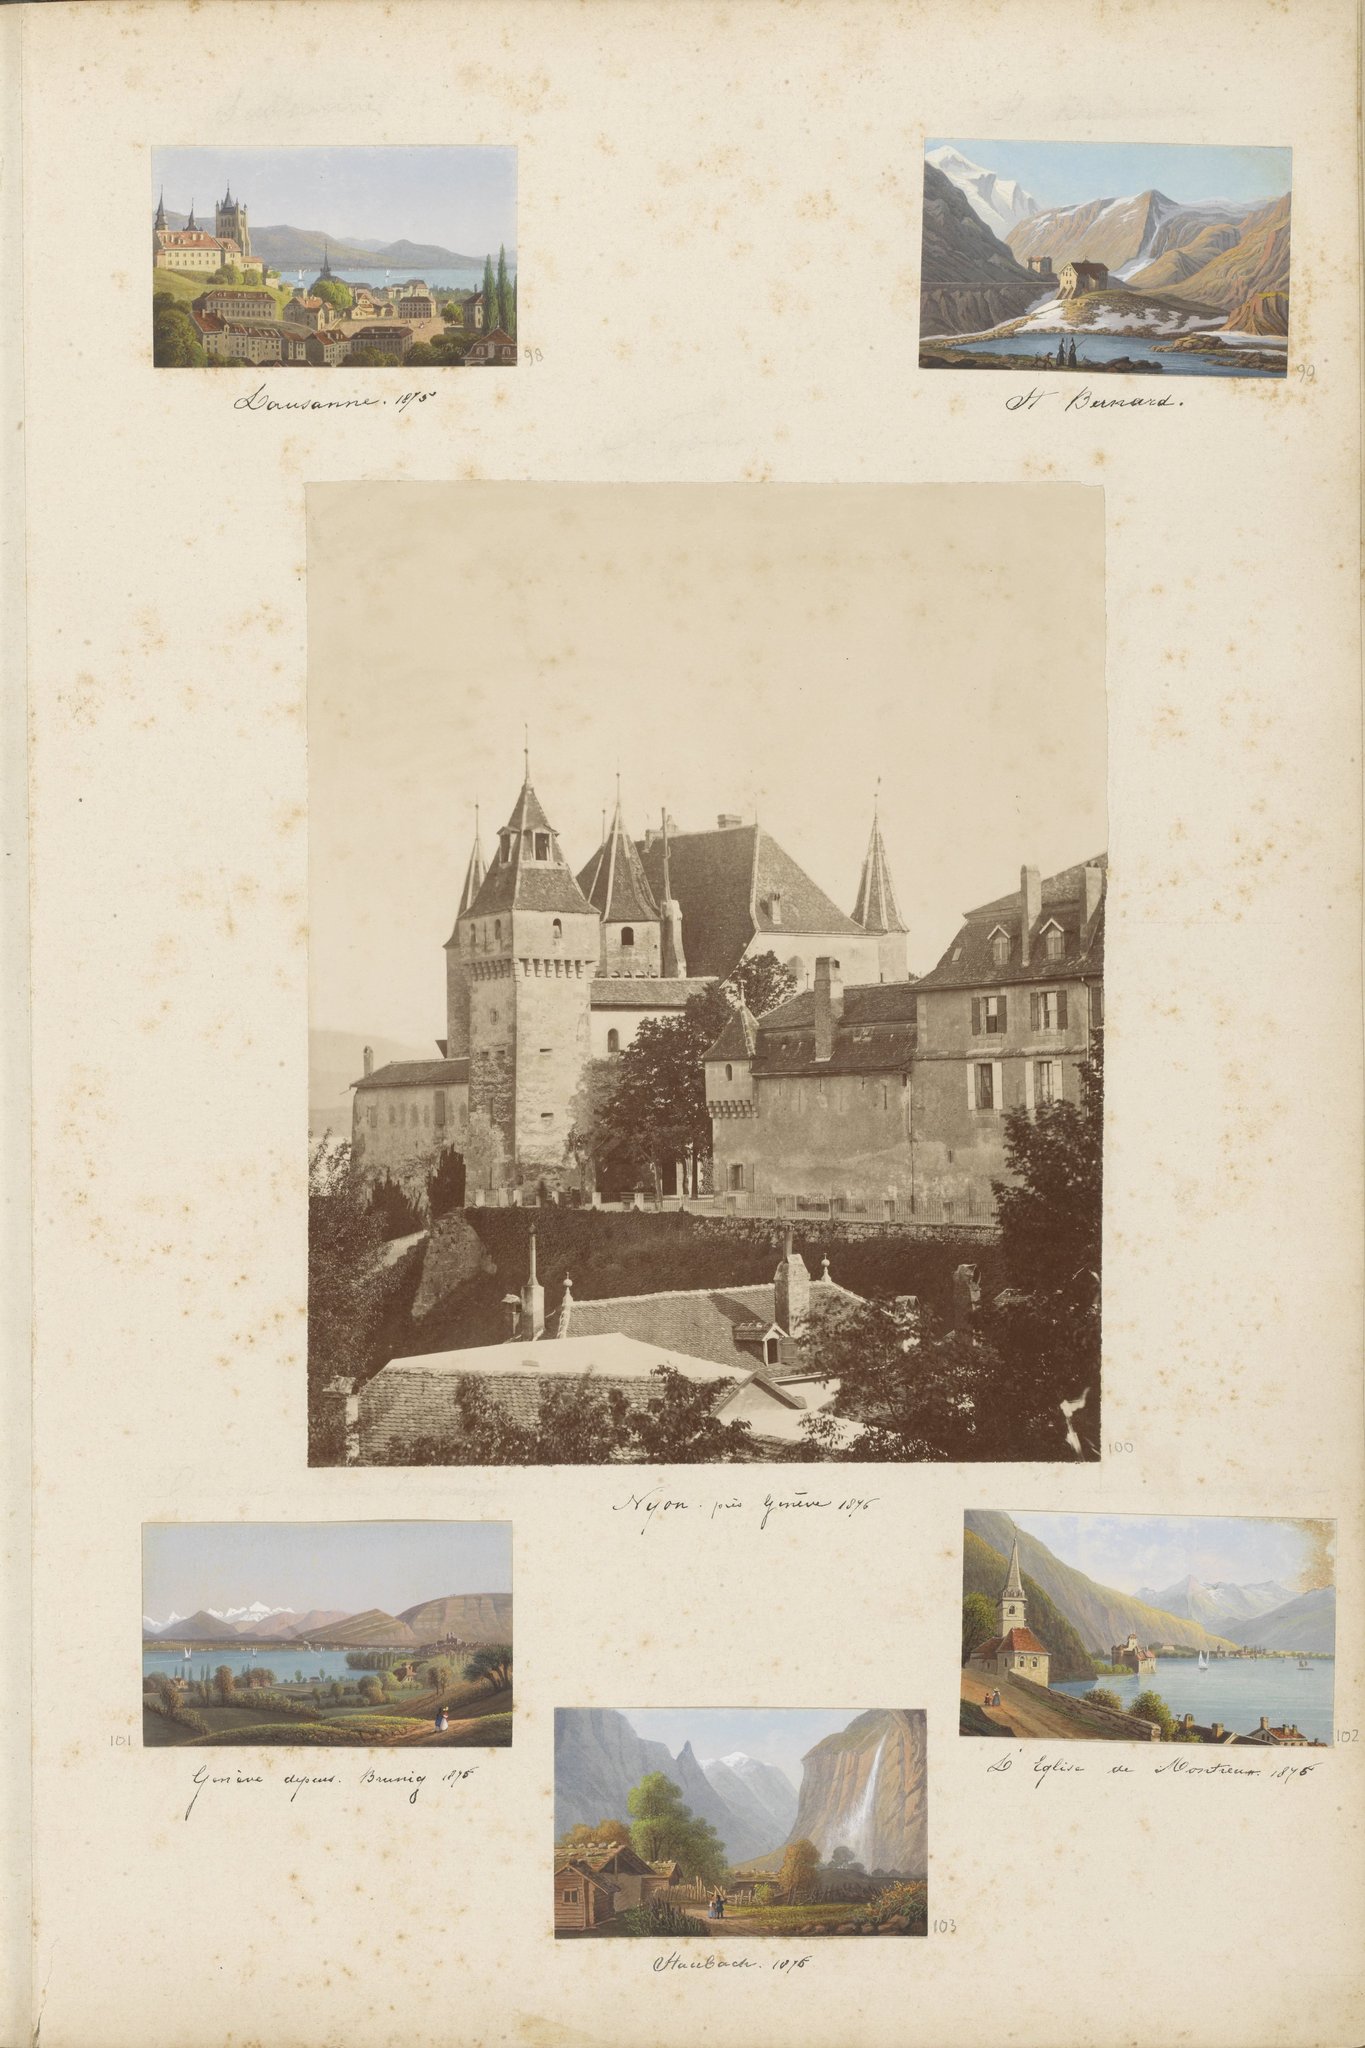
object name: print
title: Gezicht op een kapel in de bergen, vermoedelijk bij de Sint-Bernardpas in Zwitserland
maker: Anonymous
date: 1876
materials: paper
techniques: lithograph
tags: mountain-range, snow peaks, church (exterior) - qq - small church, chapel, switzerland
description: Onderdeel van Fotoalbum van Robert Daniel Crommelin (1841-1907).